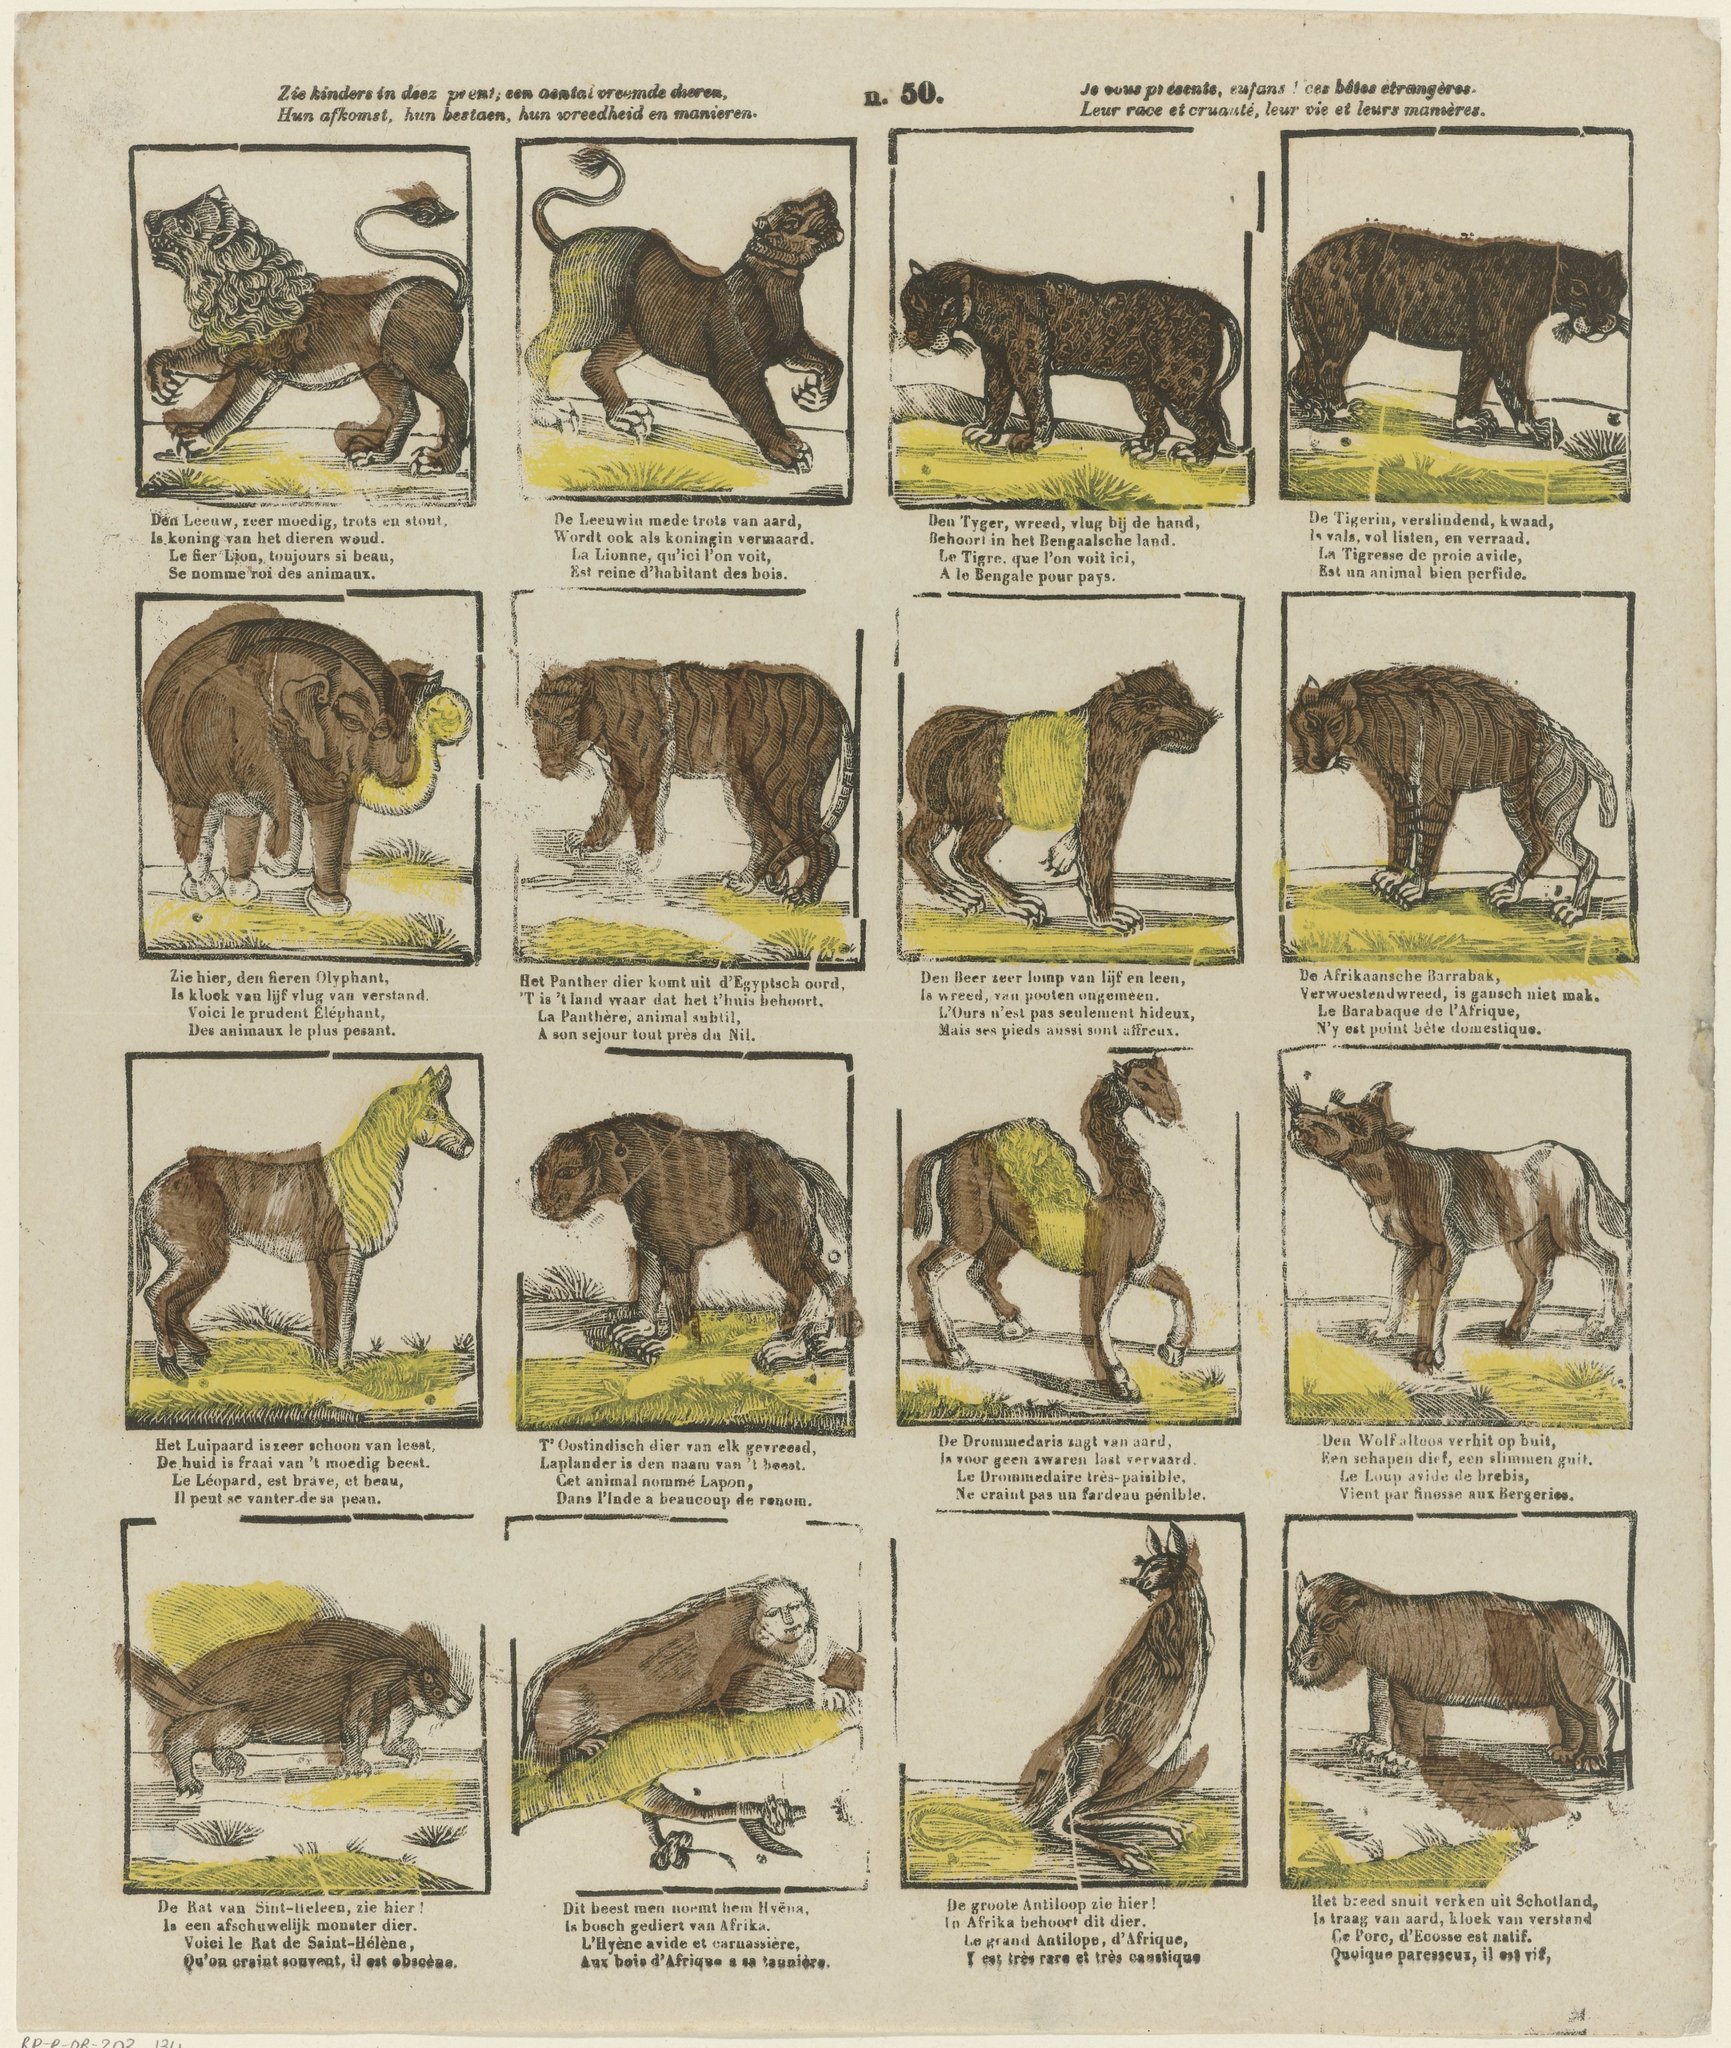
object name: print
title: Zie kinders in deez' prent, een aantal vreemde dieren, / Hun afkomst, hun bestaen, hun wreedheid en manieren / Je vous presente, enfans! ces bêtes ètrangères / Leur race et cruauté, leur vie et leurs manieres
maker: Anonymous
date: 1856-1900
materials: paper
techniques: colour, letterpress printing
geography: turnhout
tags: beasts of prey, predatory animals: tiger, hoofed animals: dromedary, animals, beasts of prey, predatory animals: lion, trunked animals: elephant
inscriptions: collector's mark: Lugt 2760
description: Blad met 16 voorstellingen van dieren, zoals een leeuw, een tijger, een olifant en een zebra. Onder elke afbeelding een tweeregelig vers in het Nederlands en in het Frans. Genummerd midden boven: n. 50.